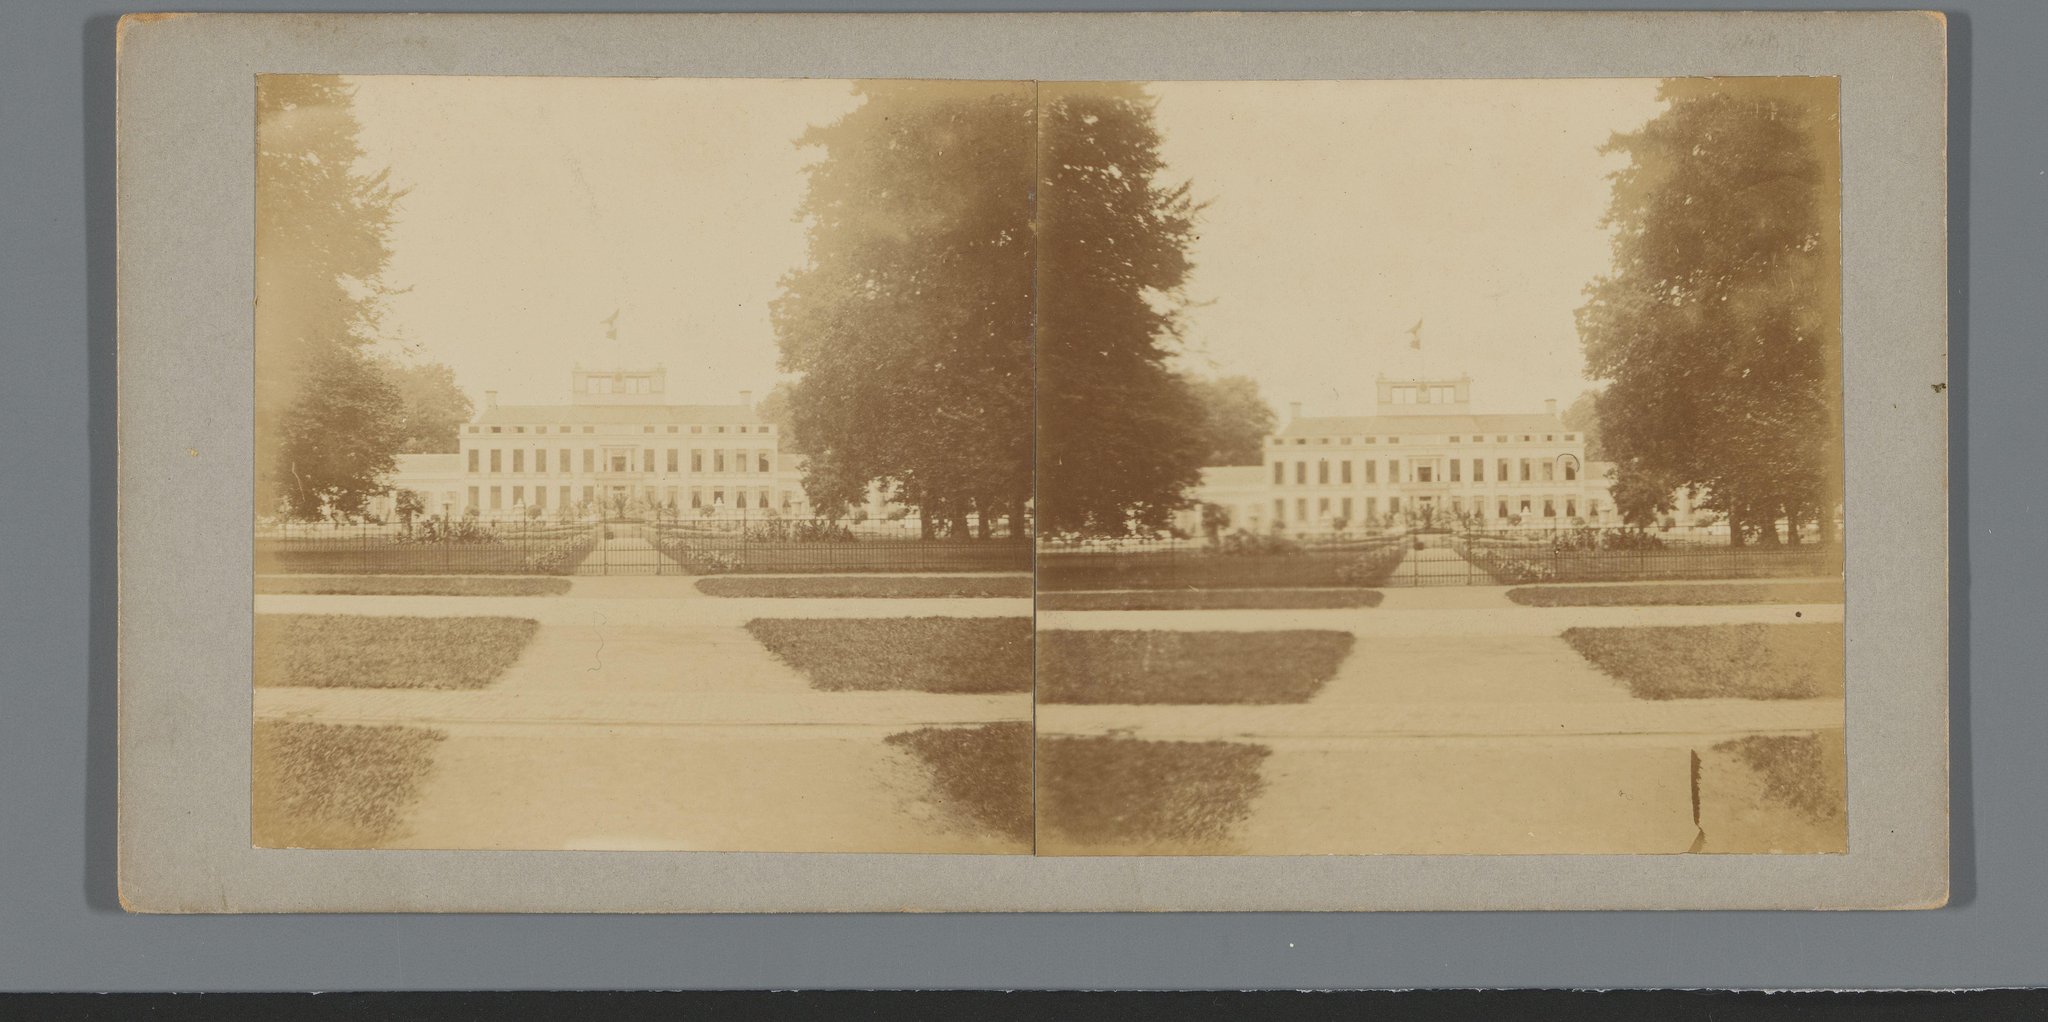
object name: stereograph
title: Soestdijk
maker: Anonymous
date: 1890-1920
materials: cardboard, photographic support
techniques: gelatin silver print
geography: soestdijk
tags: palace